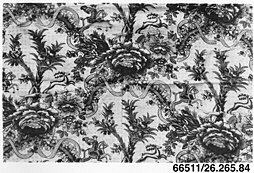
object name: print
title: Floral print with hunting scenes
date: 1785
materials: linen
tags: hunting,horses